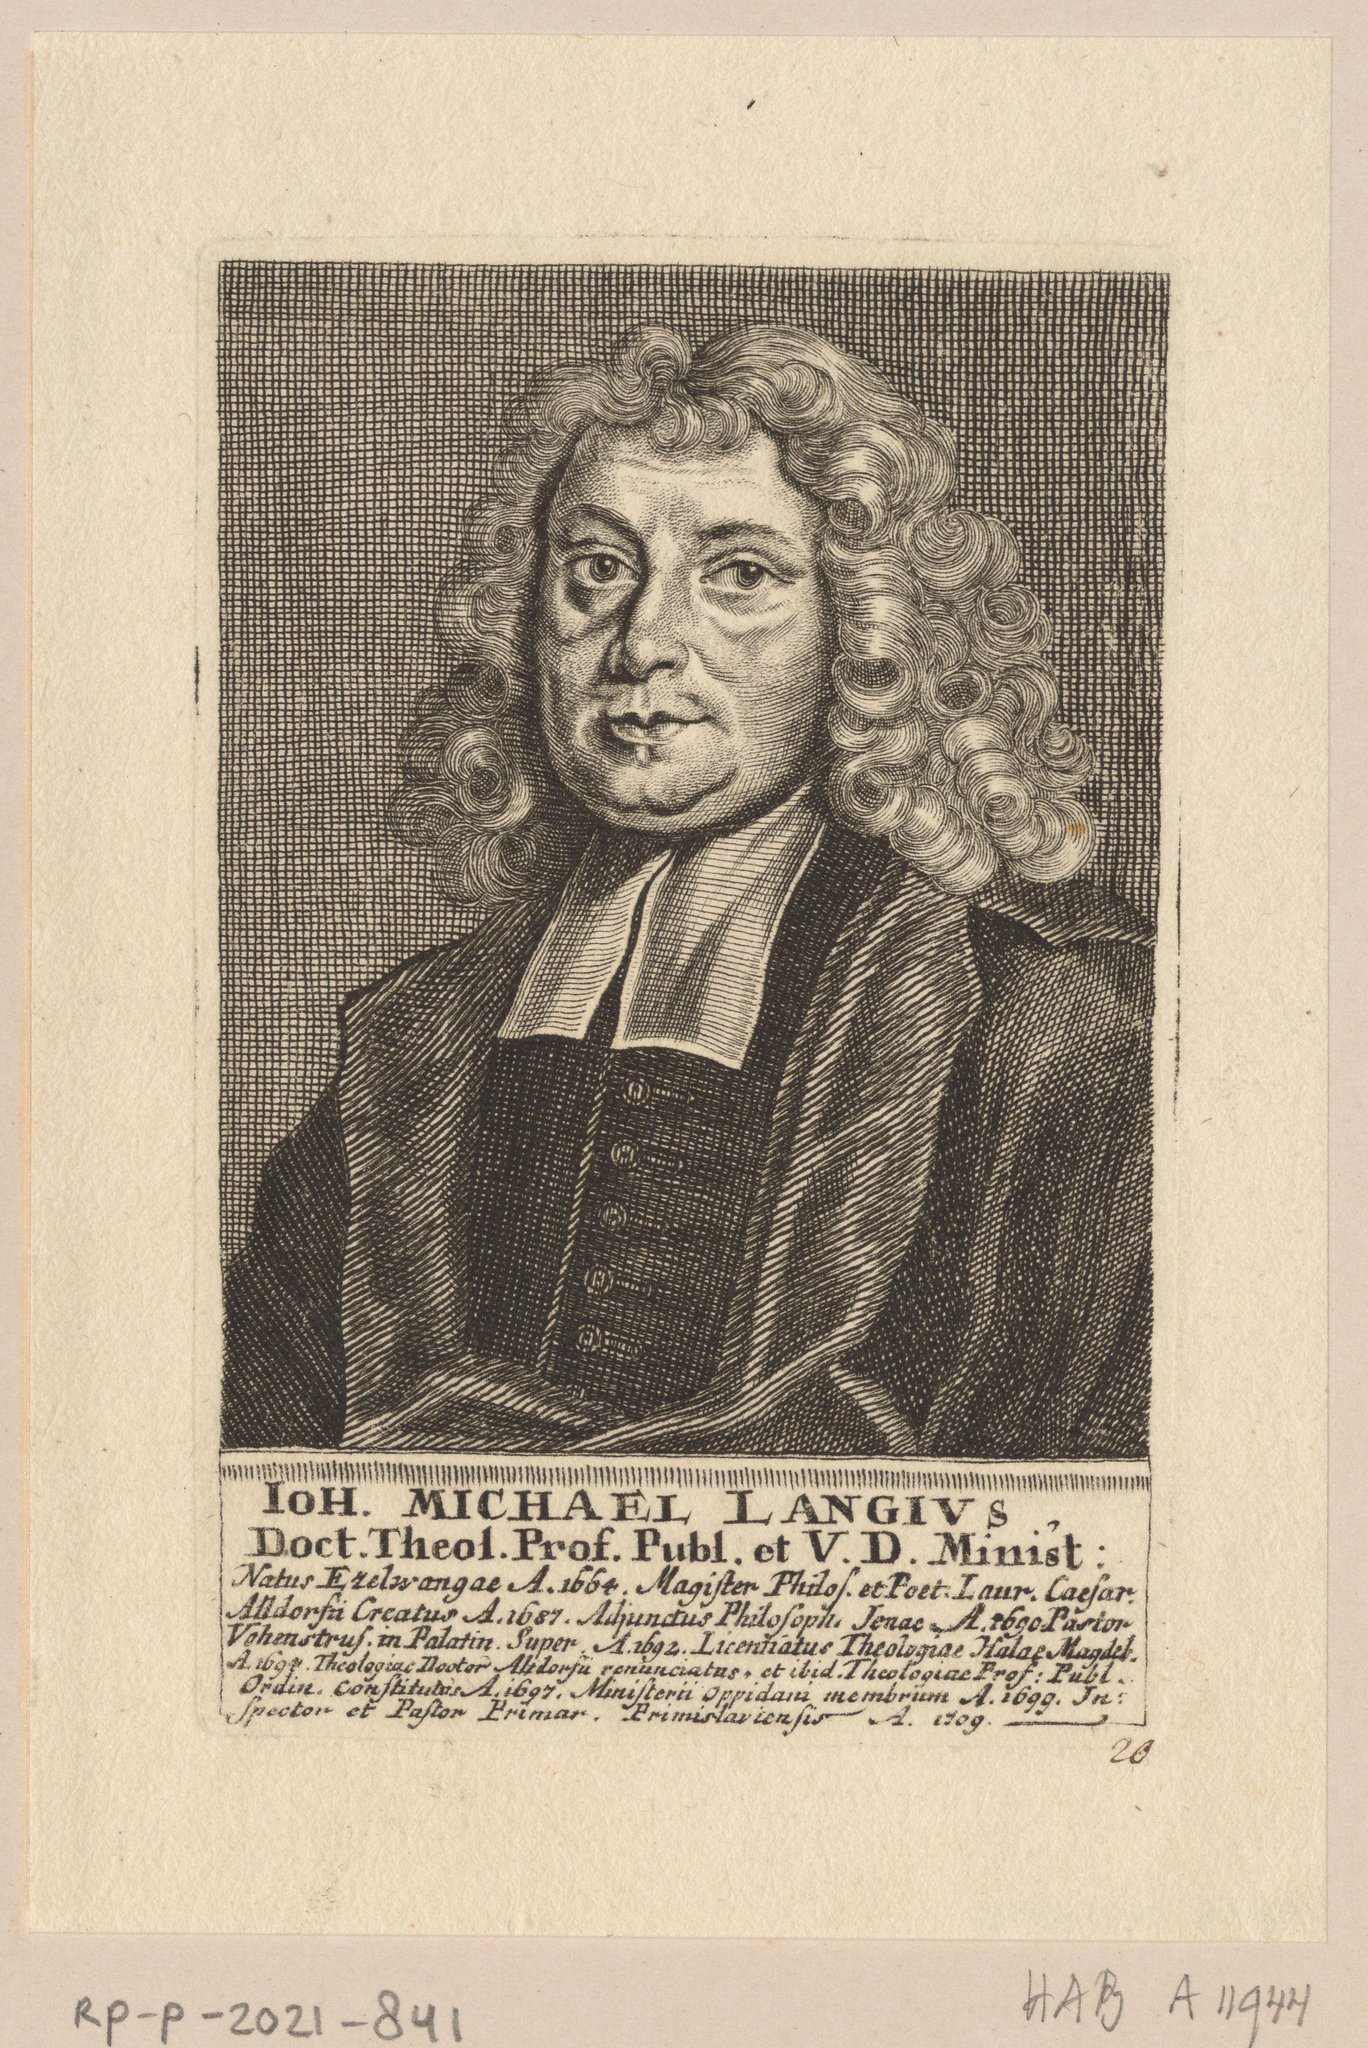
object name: print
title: Portret van Johann Michael Lang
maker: Anonymous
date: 1725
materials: paper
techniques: engraving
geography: germany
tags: theologian, historical persons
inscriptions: number: ‘20’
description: Prent waarschijnlijk uit: Roth-Scholtz, Friedrich. Icones virorum omnium ordinum eruditione omnique item genere (...). Neurenberg: erven Johann Daniel Tauber, 1725.